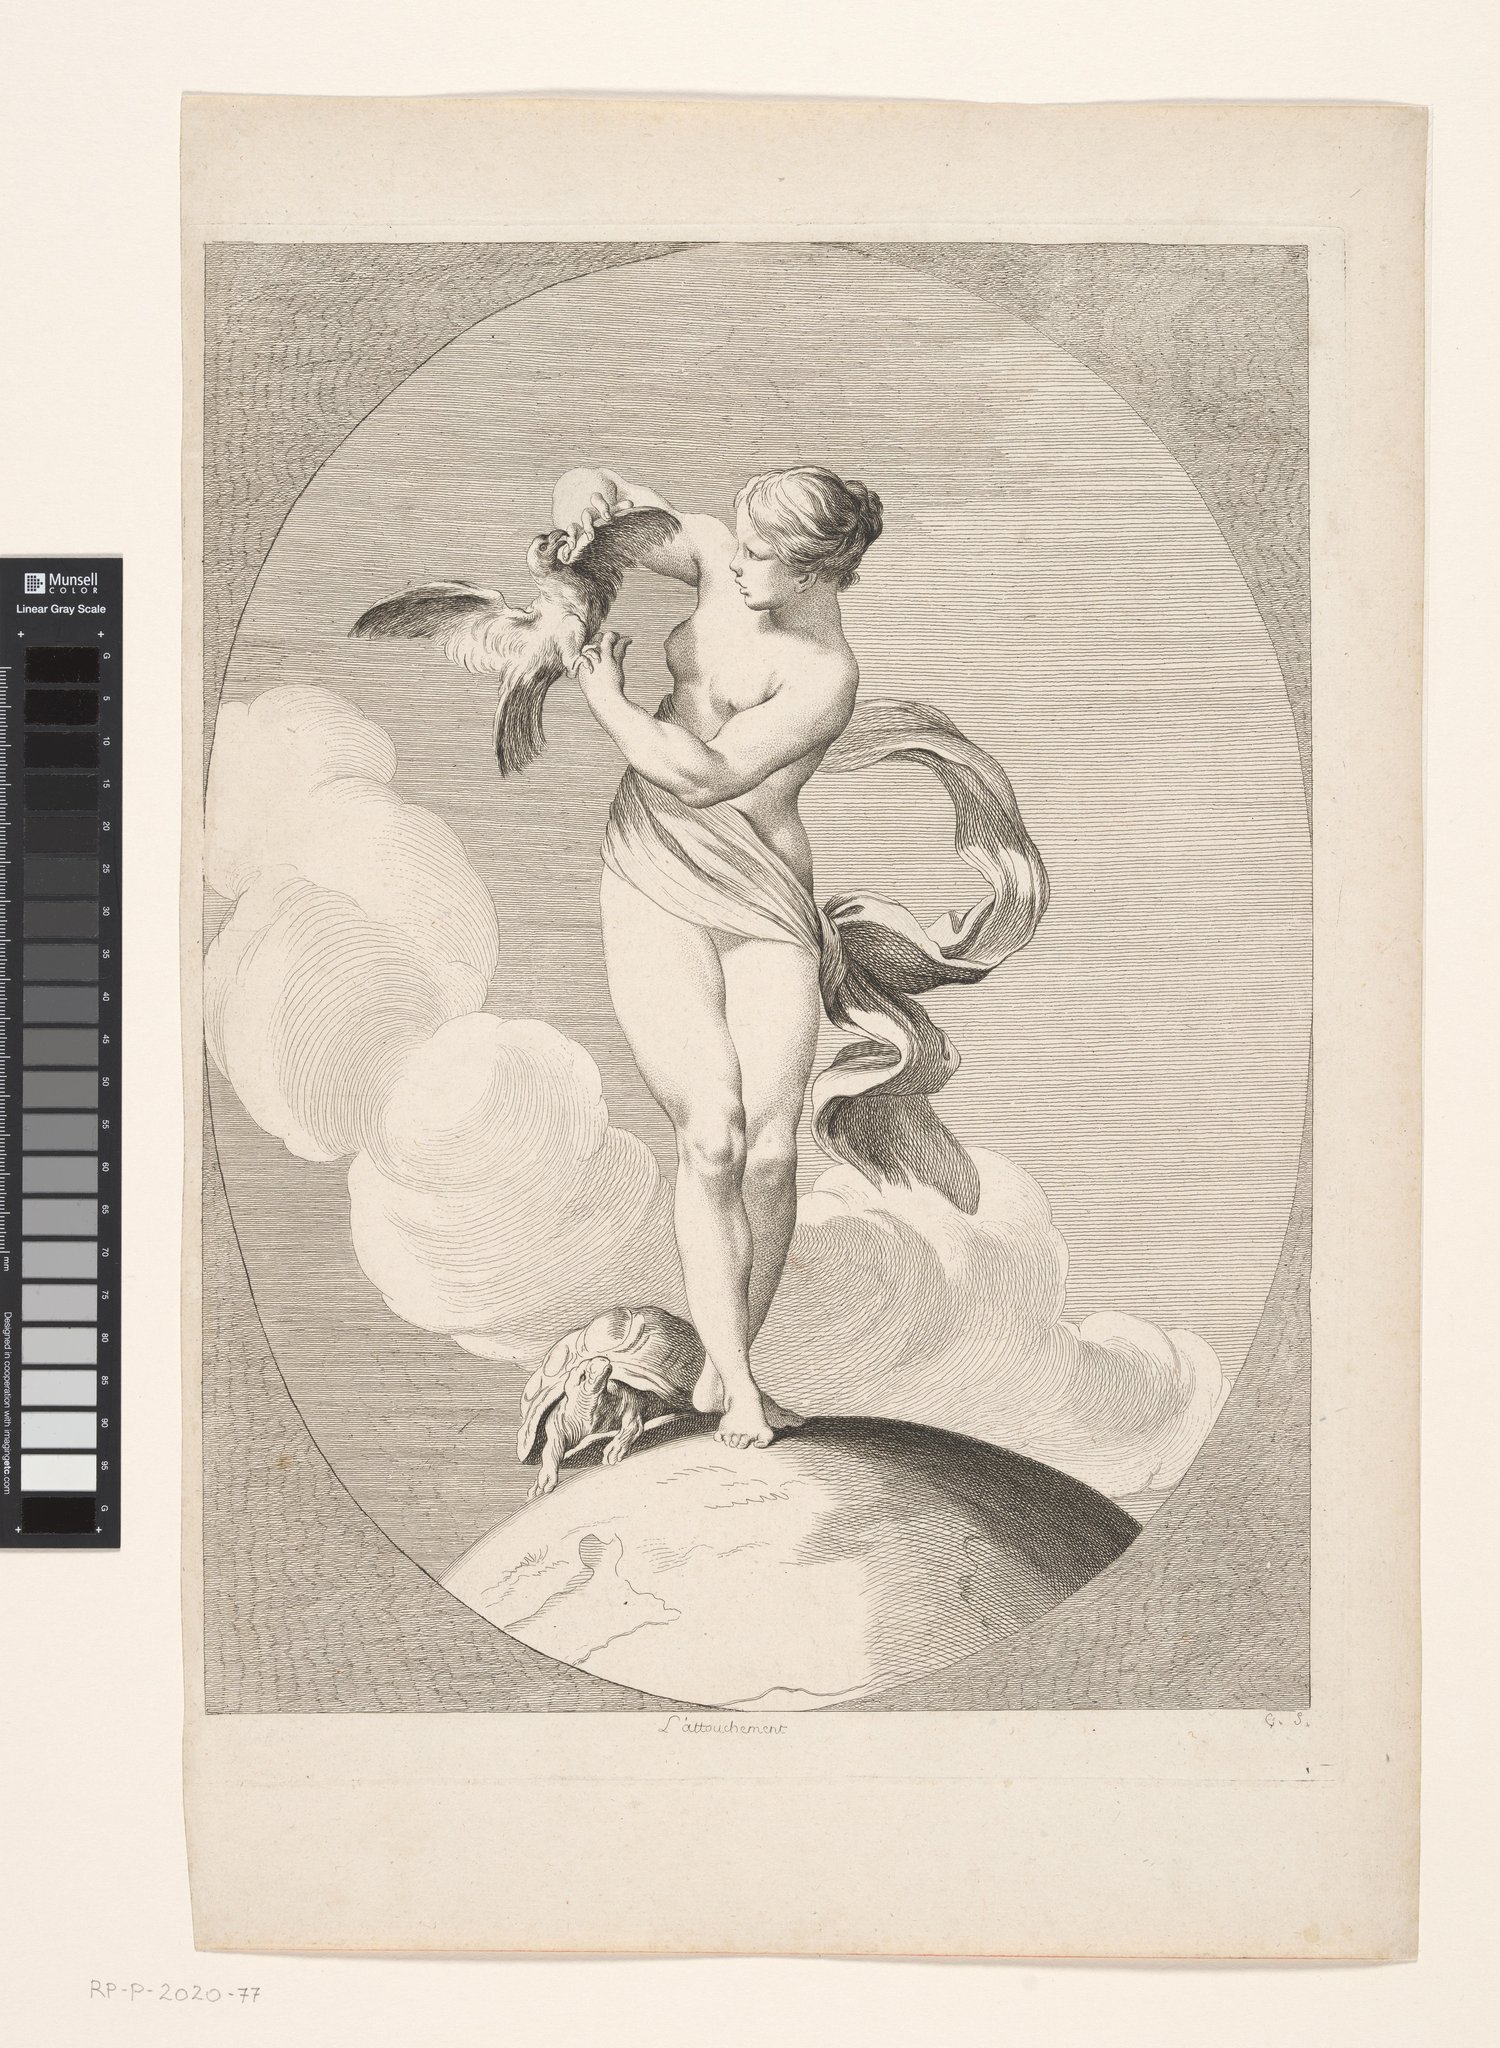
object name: print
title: Vijf zintuigen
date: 1750-1760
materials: paper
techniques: engraving, etching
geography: paris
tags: tortoises, turtles, predatory birds, feeling (one of the five senses) - aa - female human figure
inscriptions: collector's mark: Lugt 2228, collector's mark: Lugt 2760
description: Proefdruk voor de definitieve tekst, onbeschreven in de literatuur.